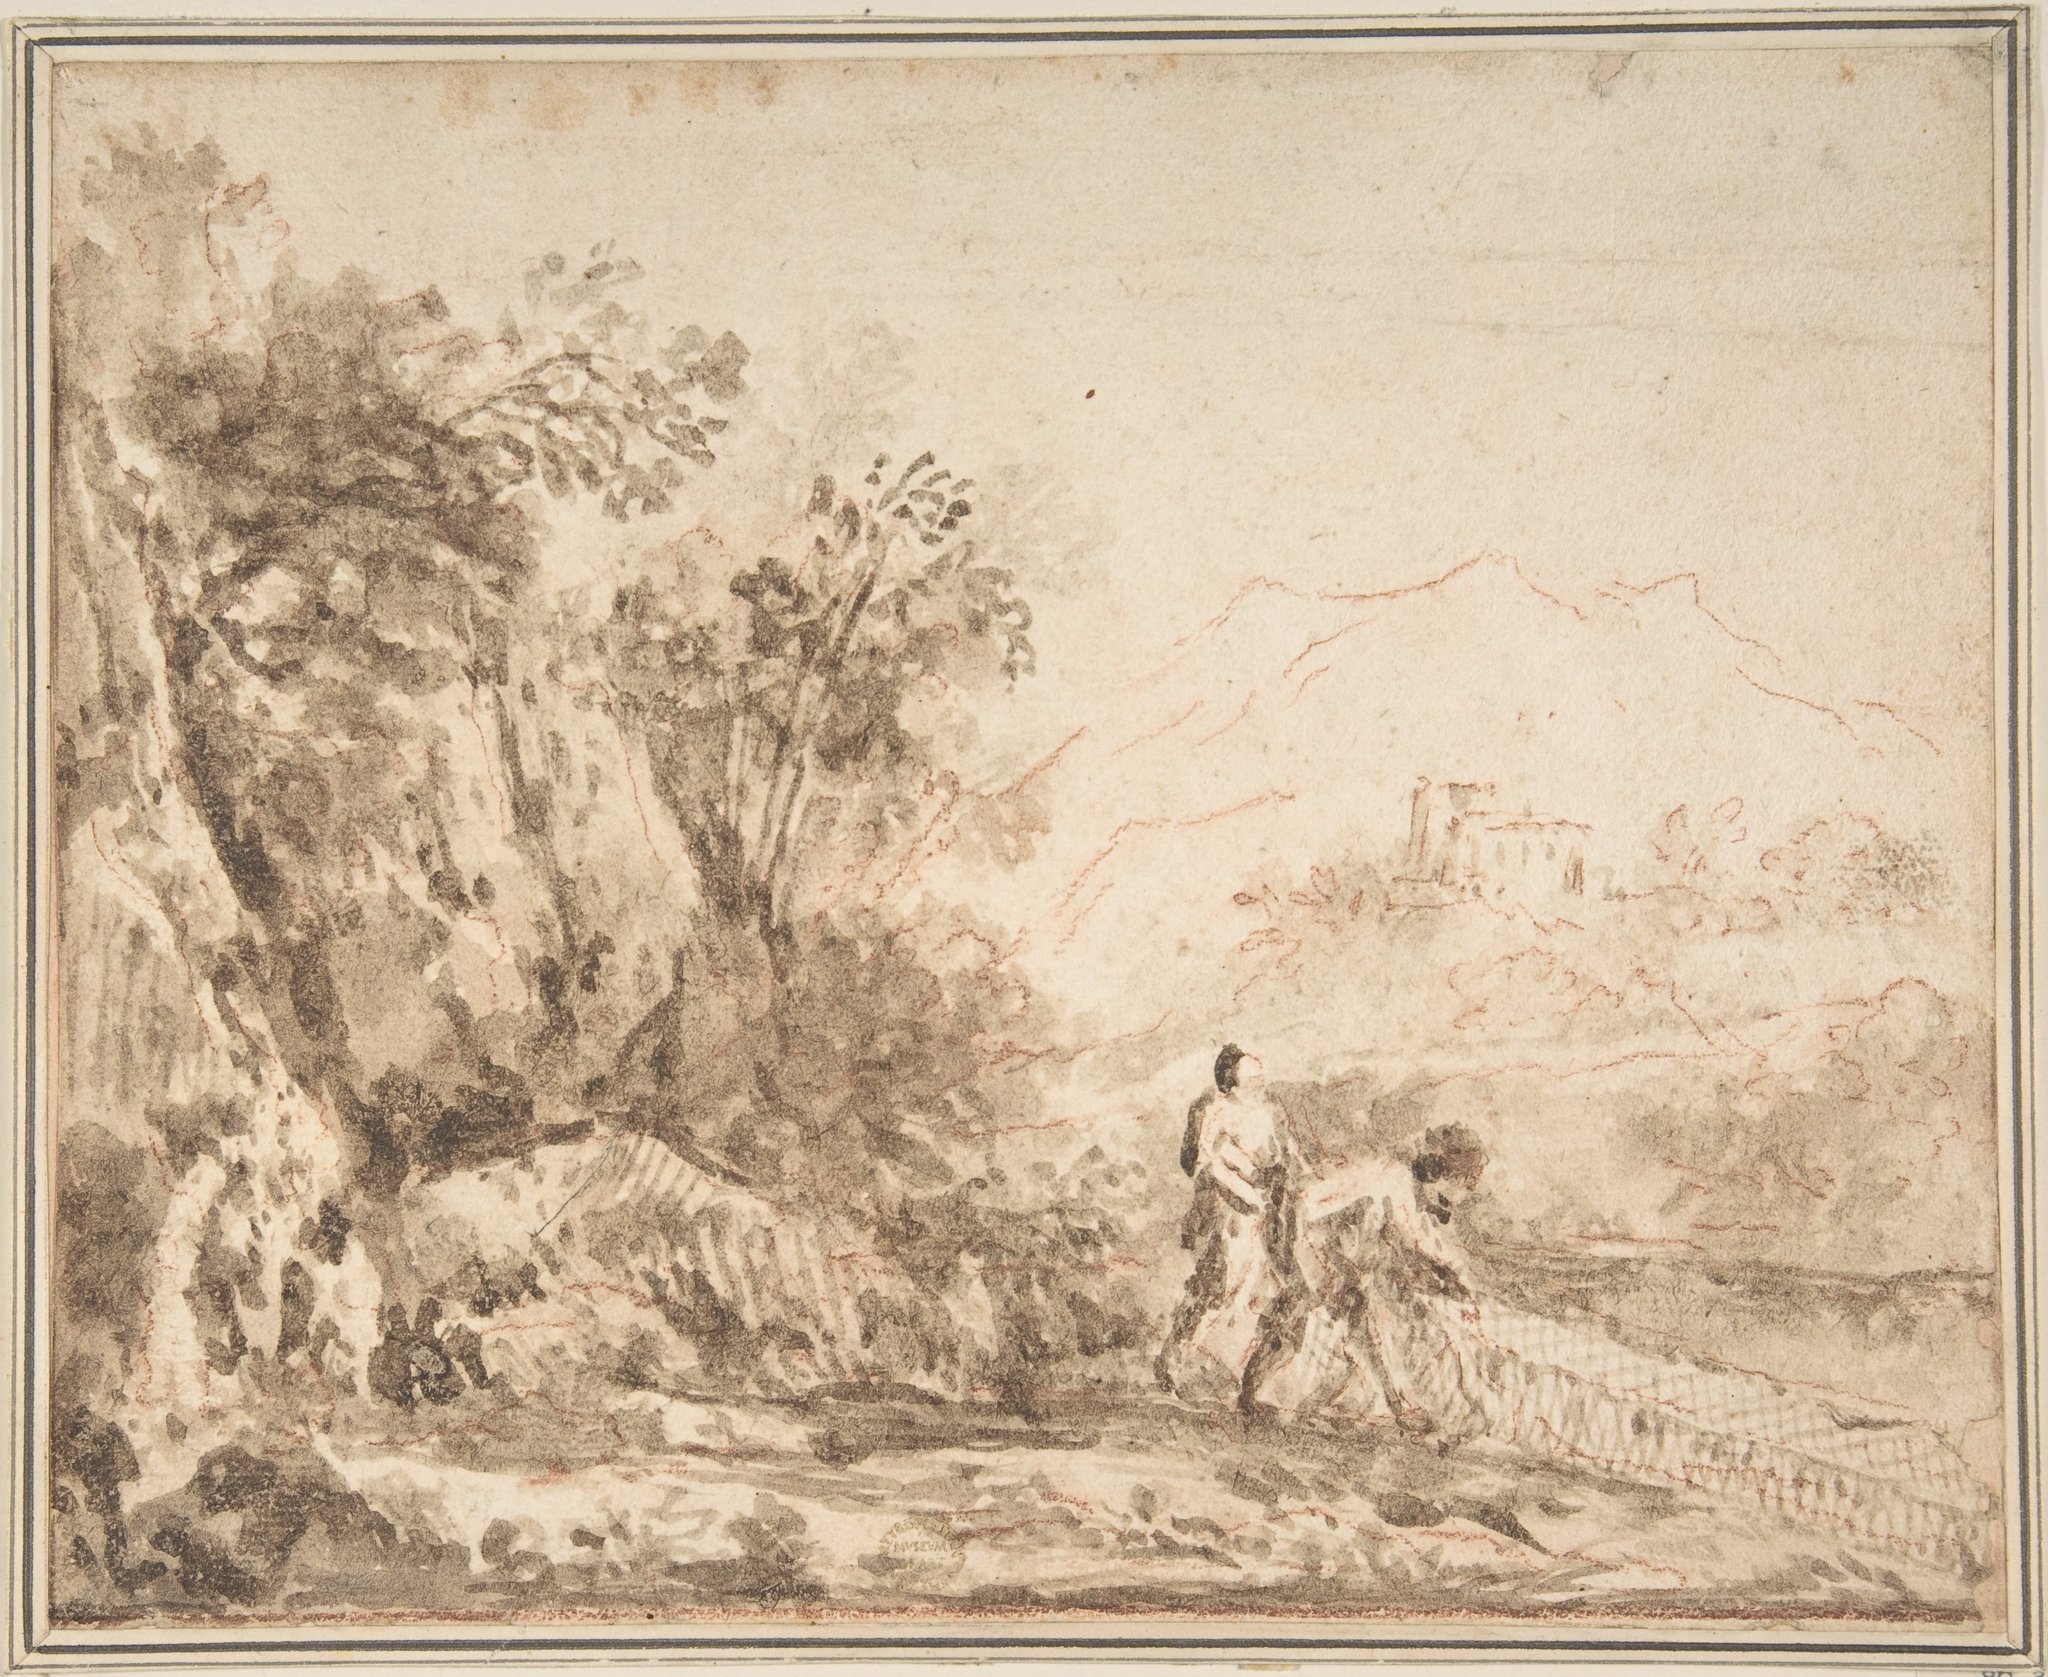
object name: drawing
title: Landscape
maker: anonymous, italian, 18th century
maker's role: artist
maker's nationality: italian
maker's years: 1700-1800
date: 1701-1800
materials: chalk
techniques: wash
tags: human figures,mountains,landscapes,trees